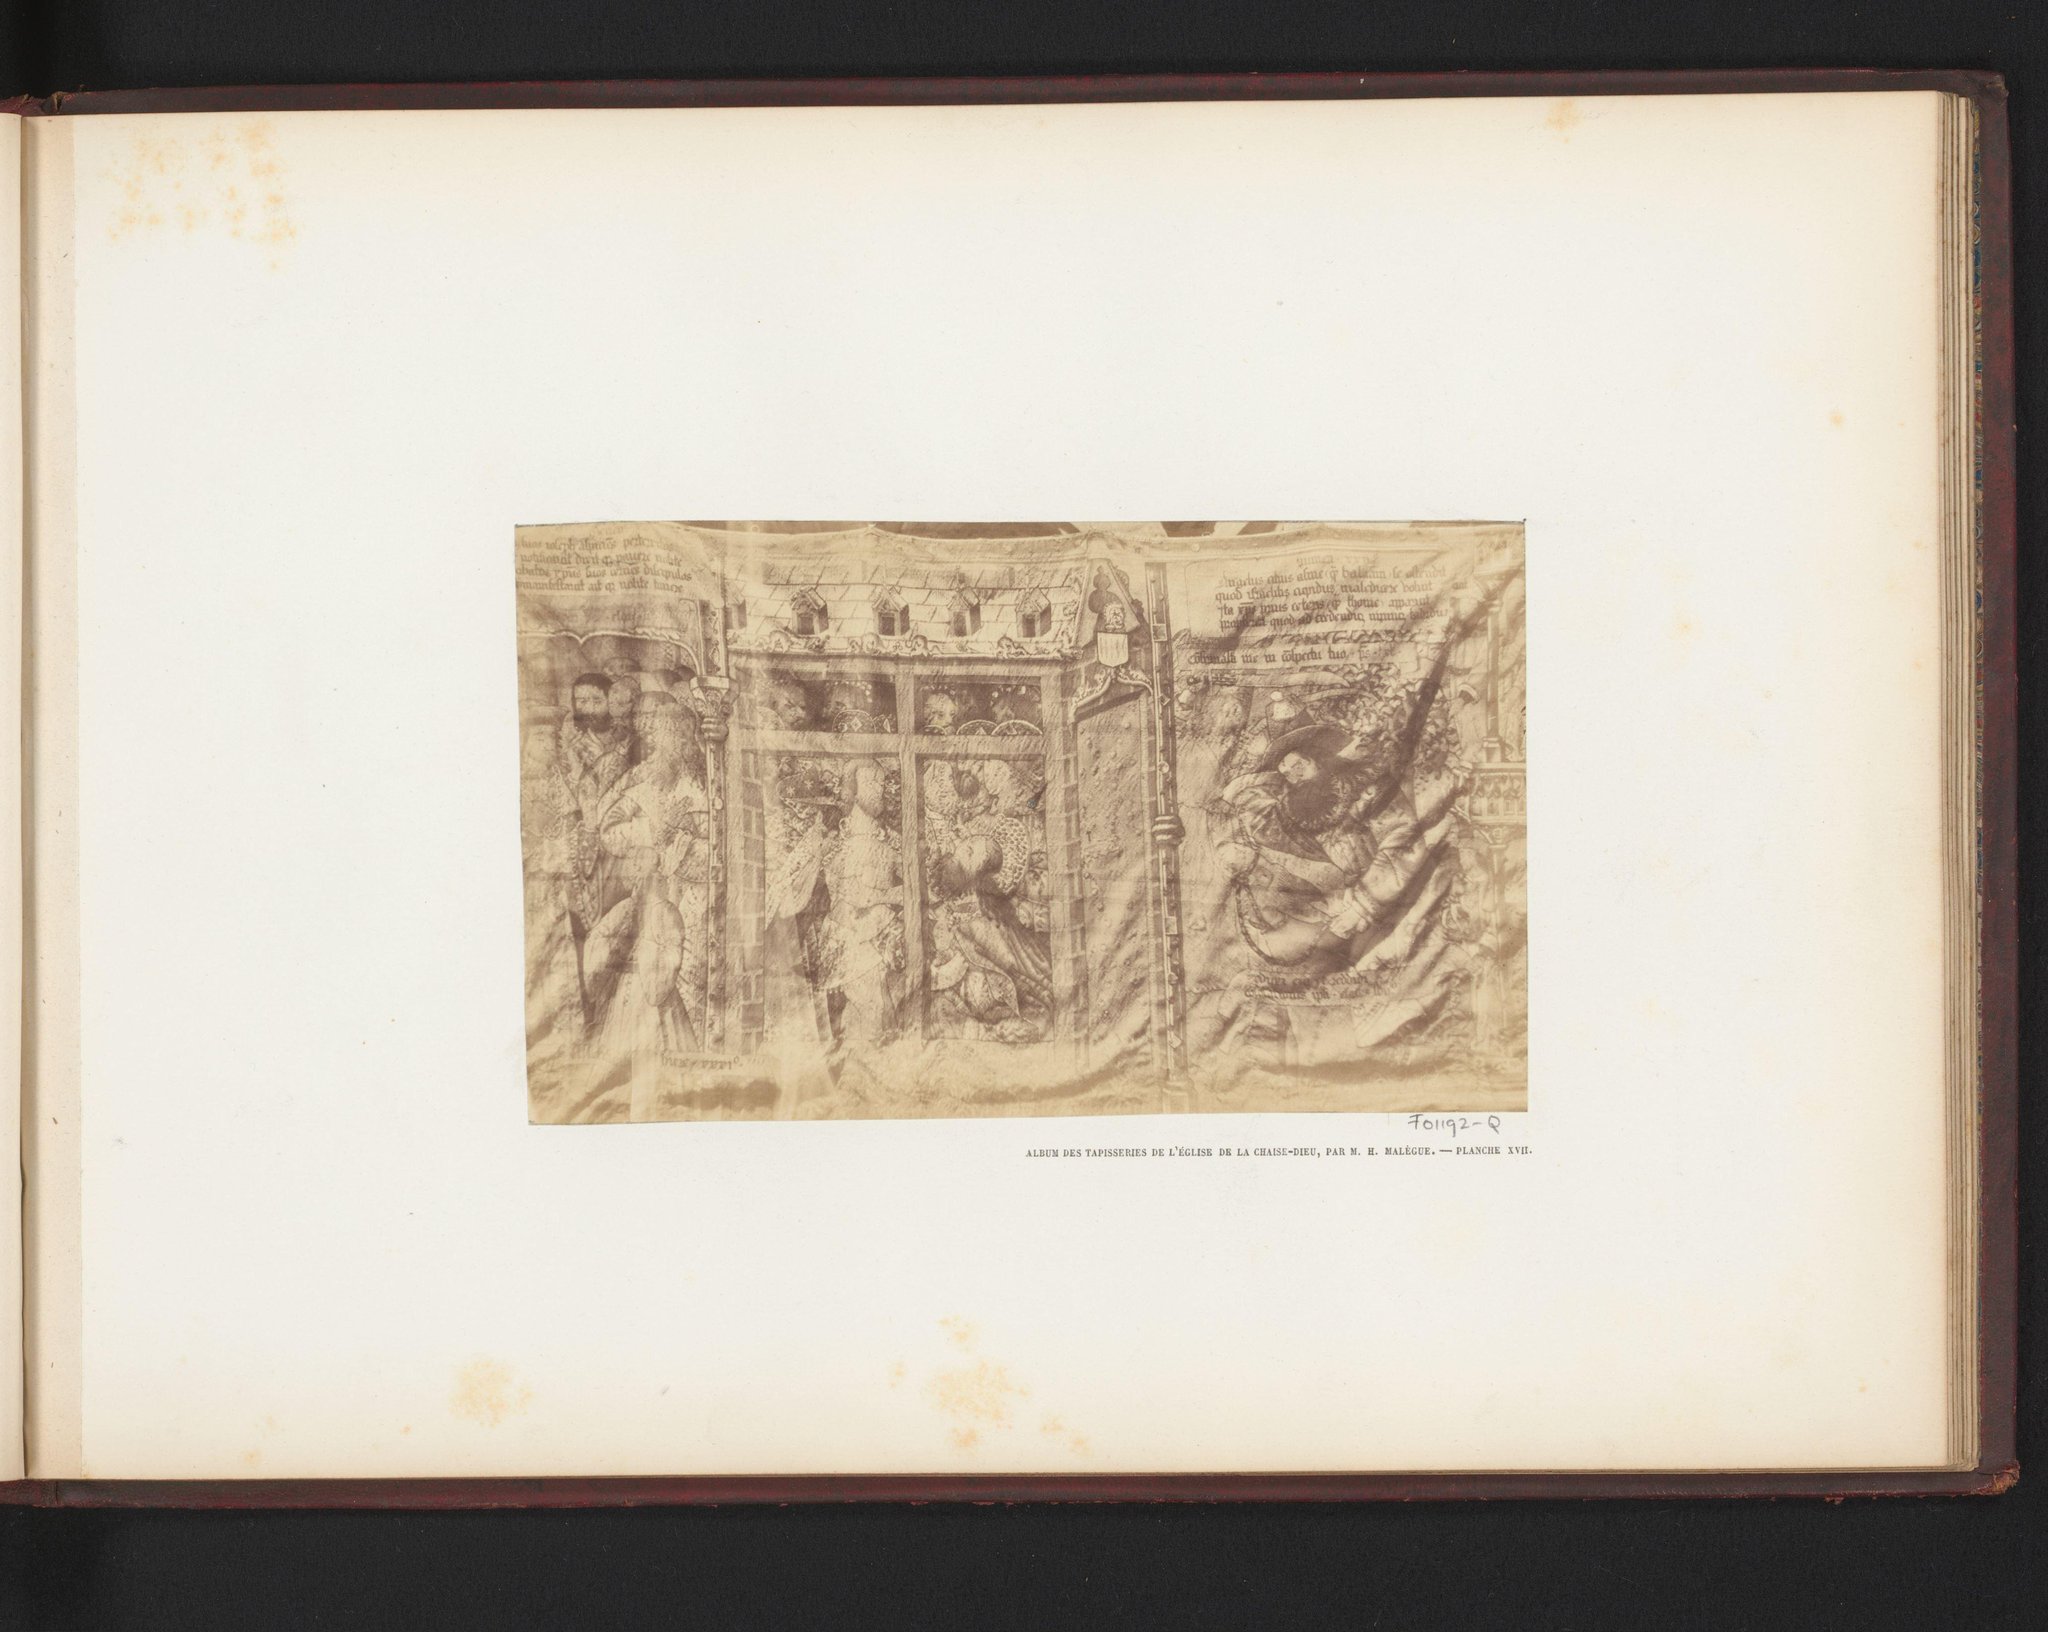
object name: page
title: Tapijt met de verschijning van Christus aan de discipelen en prefiguraties in een kerk te La Chaise-Dieu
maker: hippolyte malègue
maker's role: archeoloog, fotograaf, schrijver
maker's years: 1825-1901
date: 1868-1873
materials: photographic support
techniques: albumen print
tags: tapestry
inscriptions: inscription: ‘album des tapisseries de l'église de la Chaise-Dieu, par M. H. Malegue - Planche XVII’